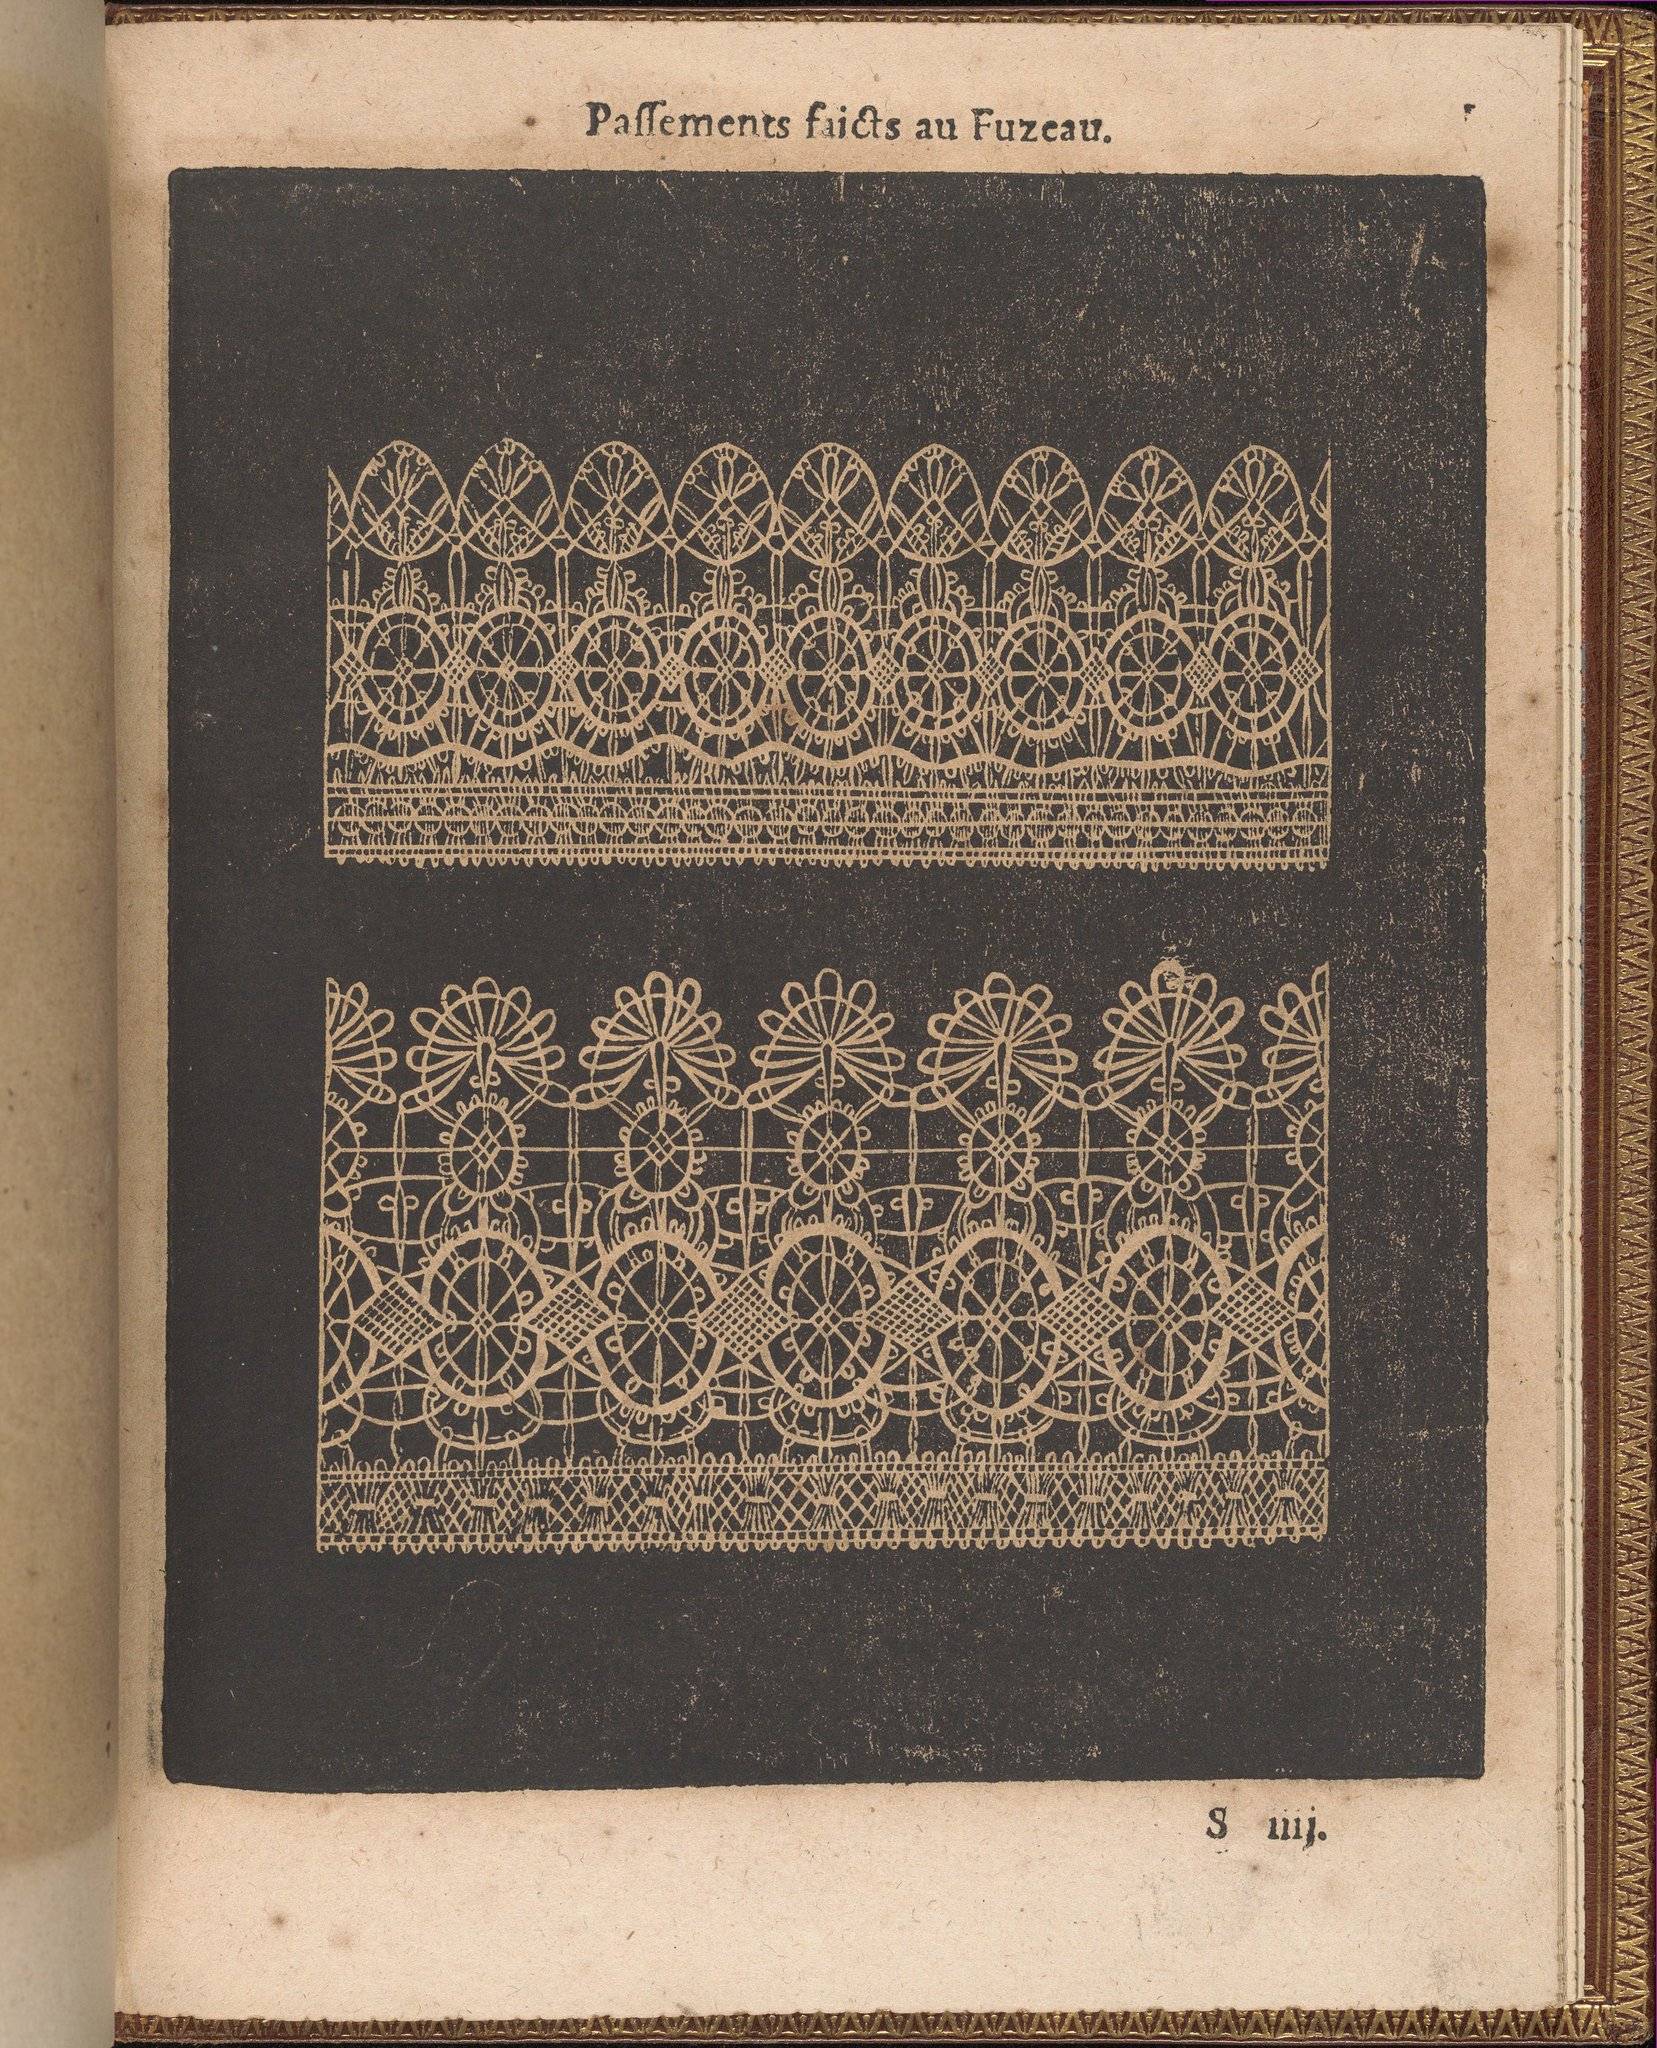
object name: book print ornament architecture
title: La Pratique de l'Aiguille, page 71 (recto)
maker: matthias mignerak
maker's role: author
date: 1605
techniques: woodcut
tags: ornament